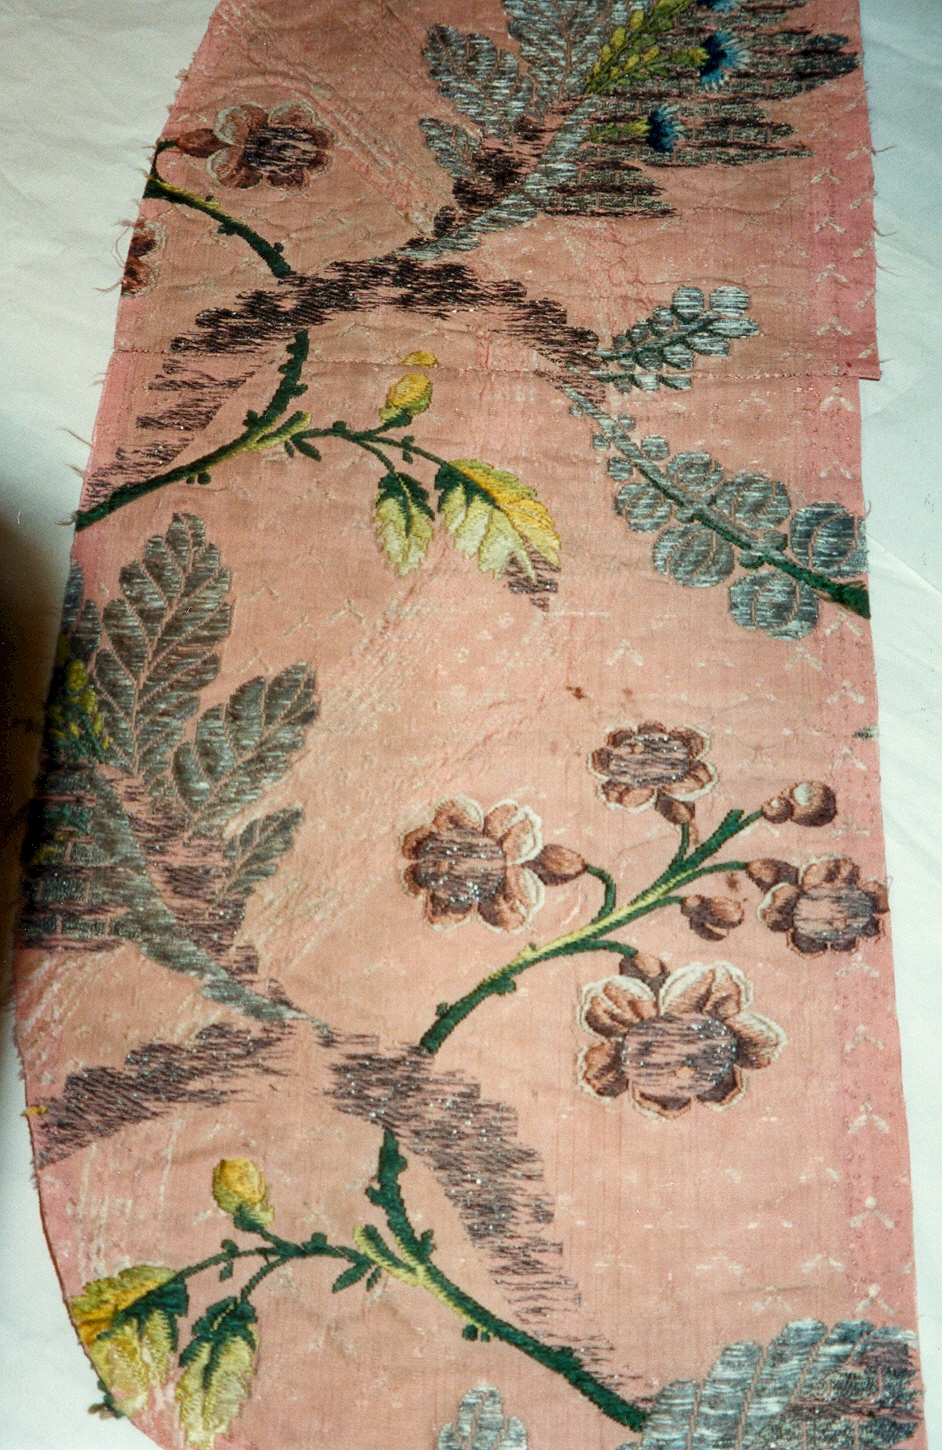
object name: chasuble fragment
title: Fragment of a chasuble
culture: french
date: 1701-1800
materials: metal, silk